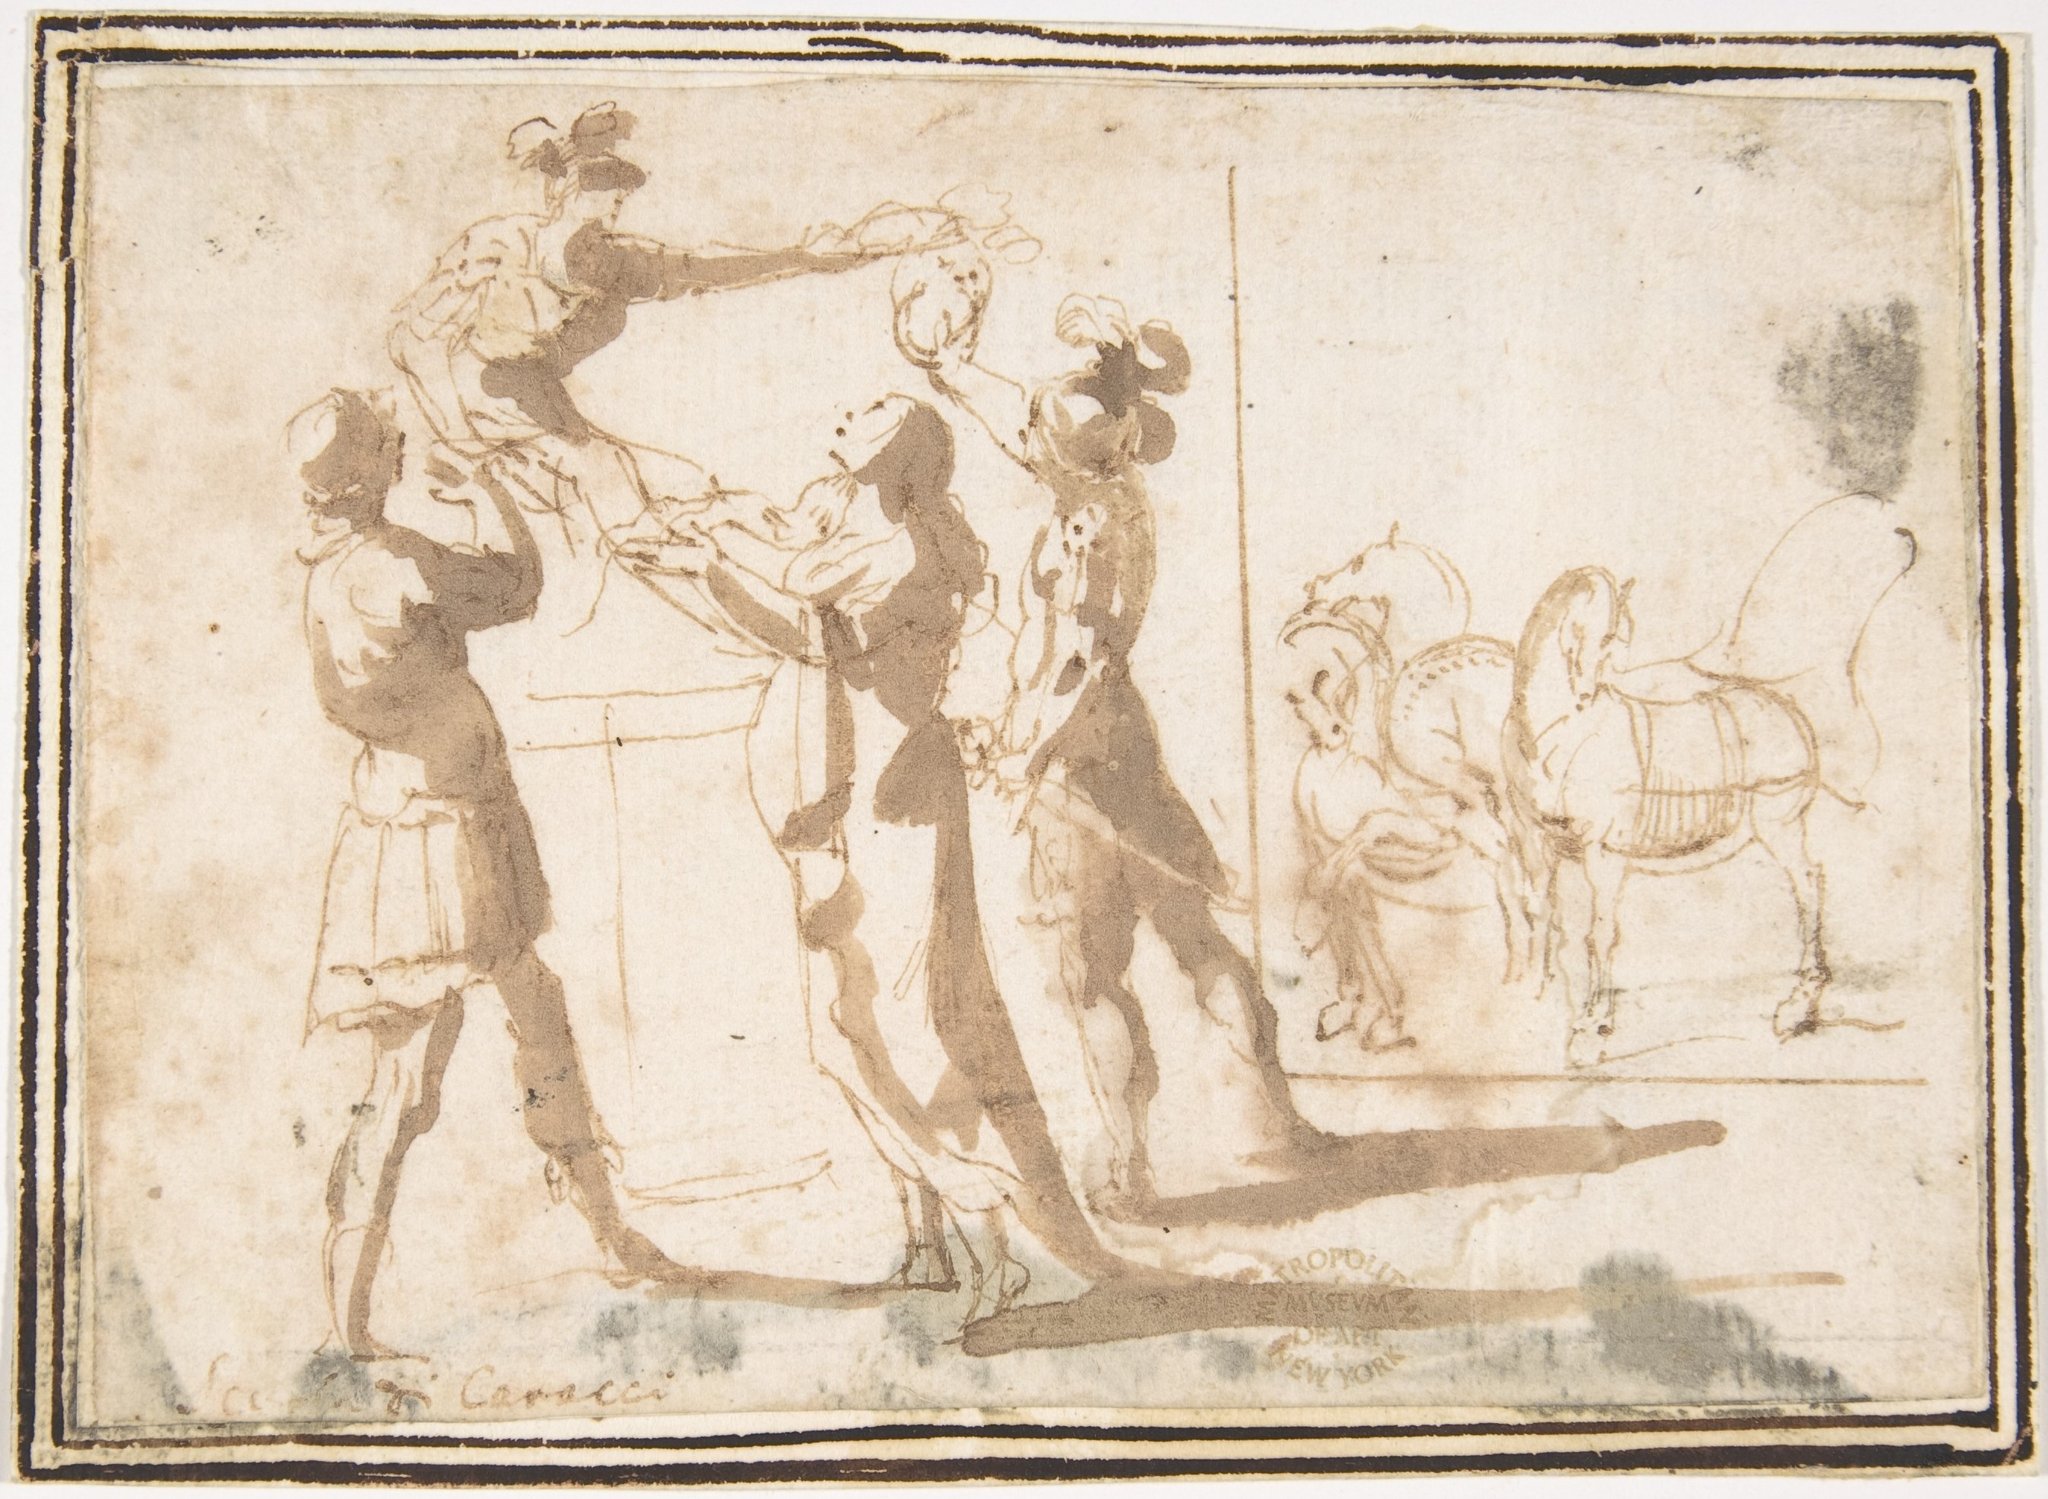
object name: drawing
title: Enthroned Warrior Distributing Crowns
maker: francesco allegrini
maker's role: artist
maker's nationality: italian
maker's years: 1615-1679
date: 1624-1663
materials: ink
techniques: brush, pen, wash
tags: soldiers,men,horses